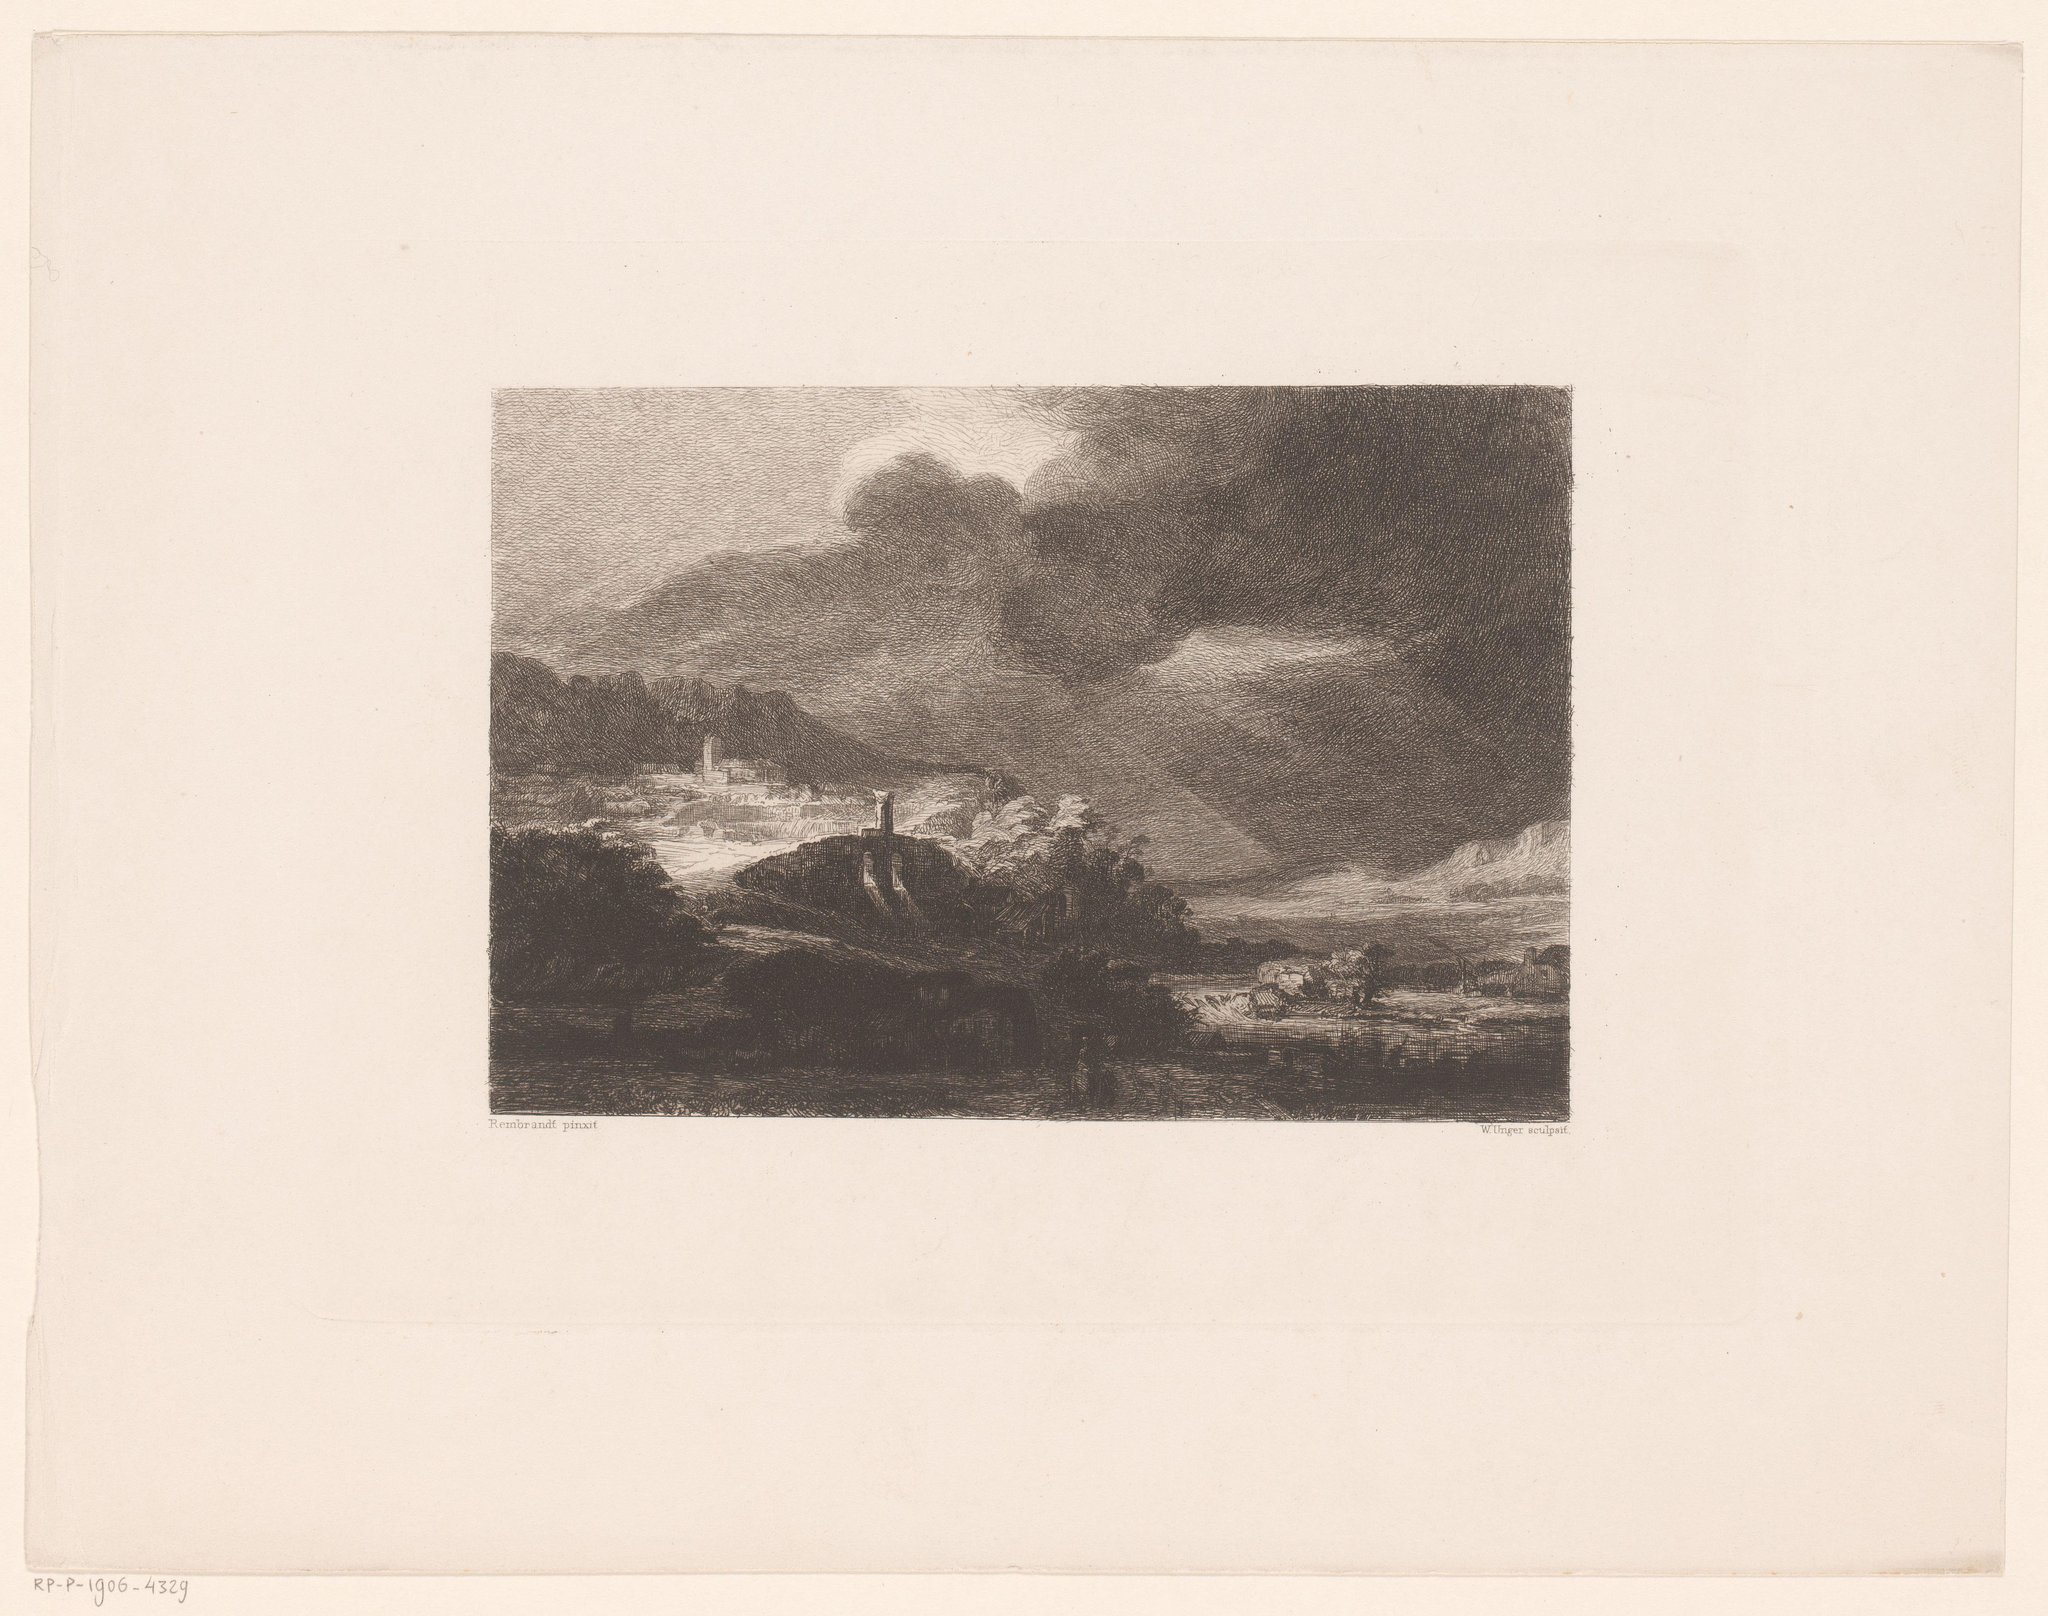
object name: print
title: Bergachtig landschap met een brug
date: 1847-1906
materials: paper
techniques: etching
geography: germany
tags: landscape with bridge, viaduct or aqueduct, mountains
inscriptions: collector's mark: Lugt 2228